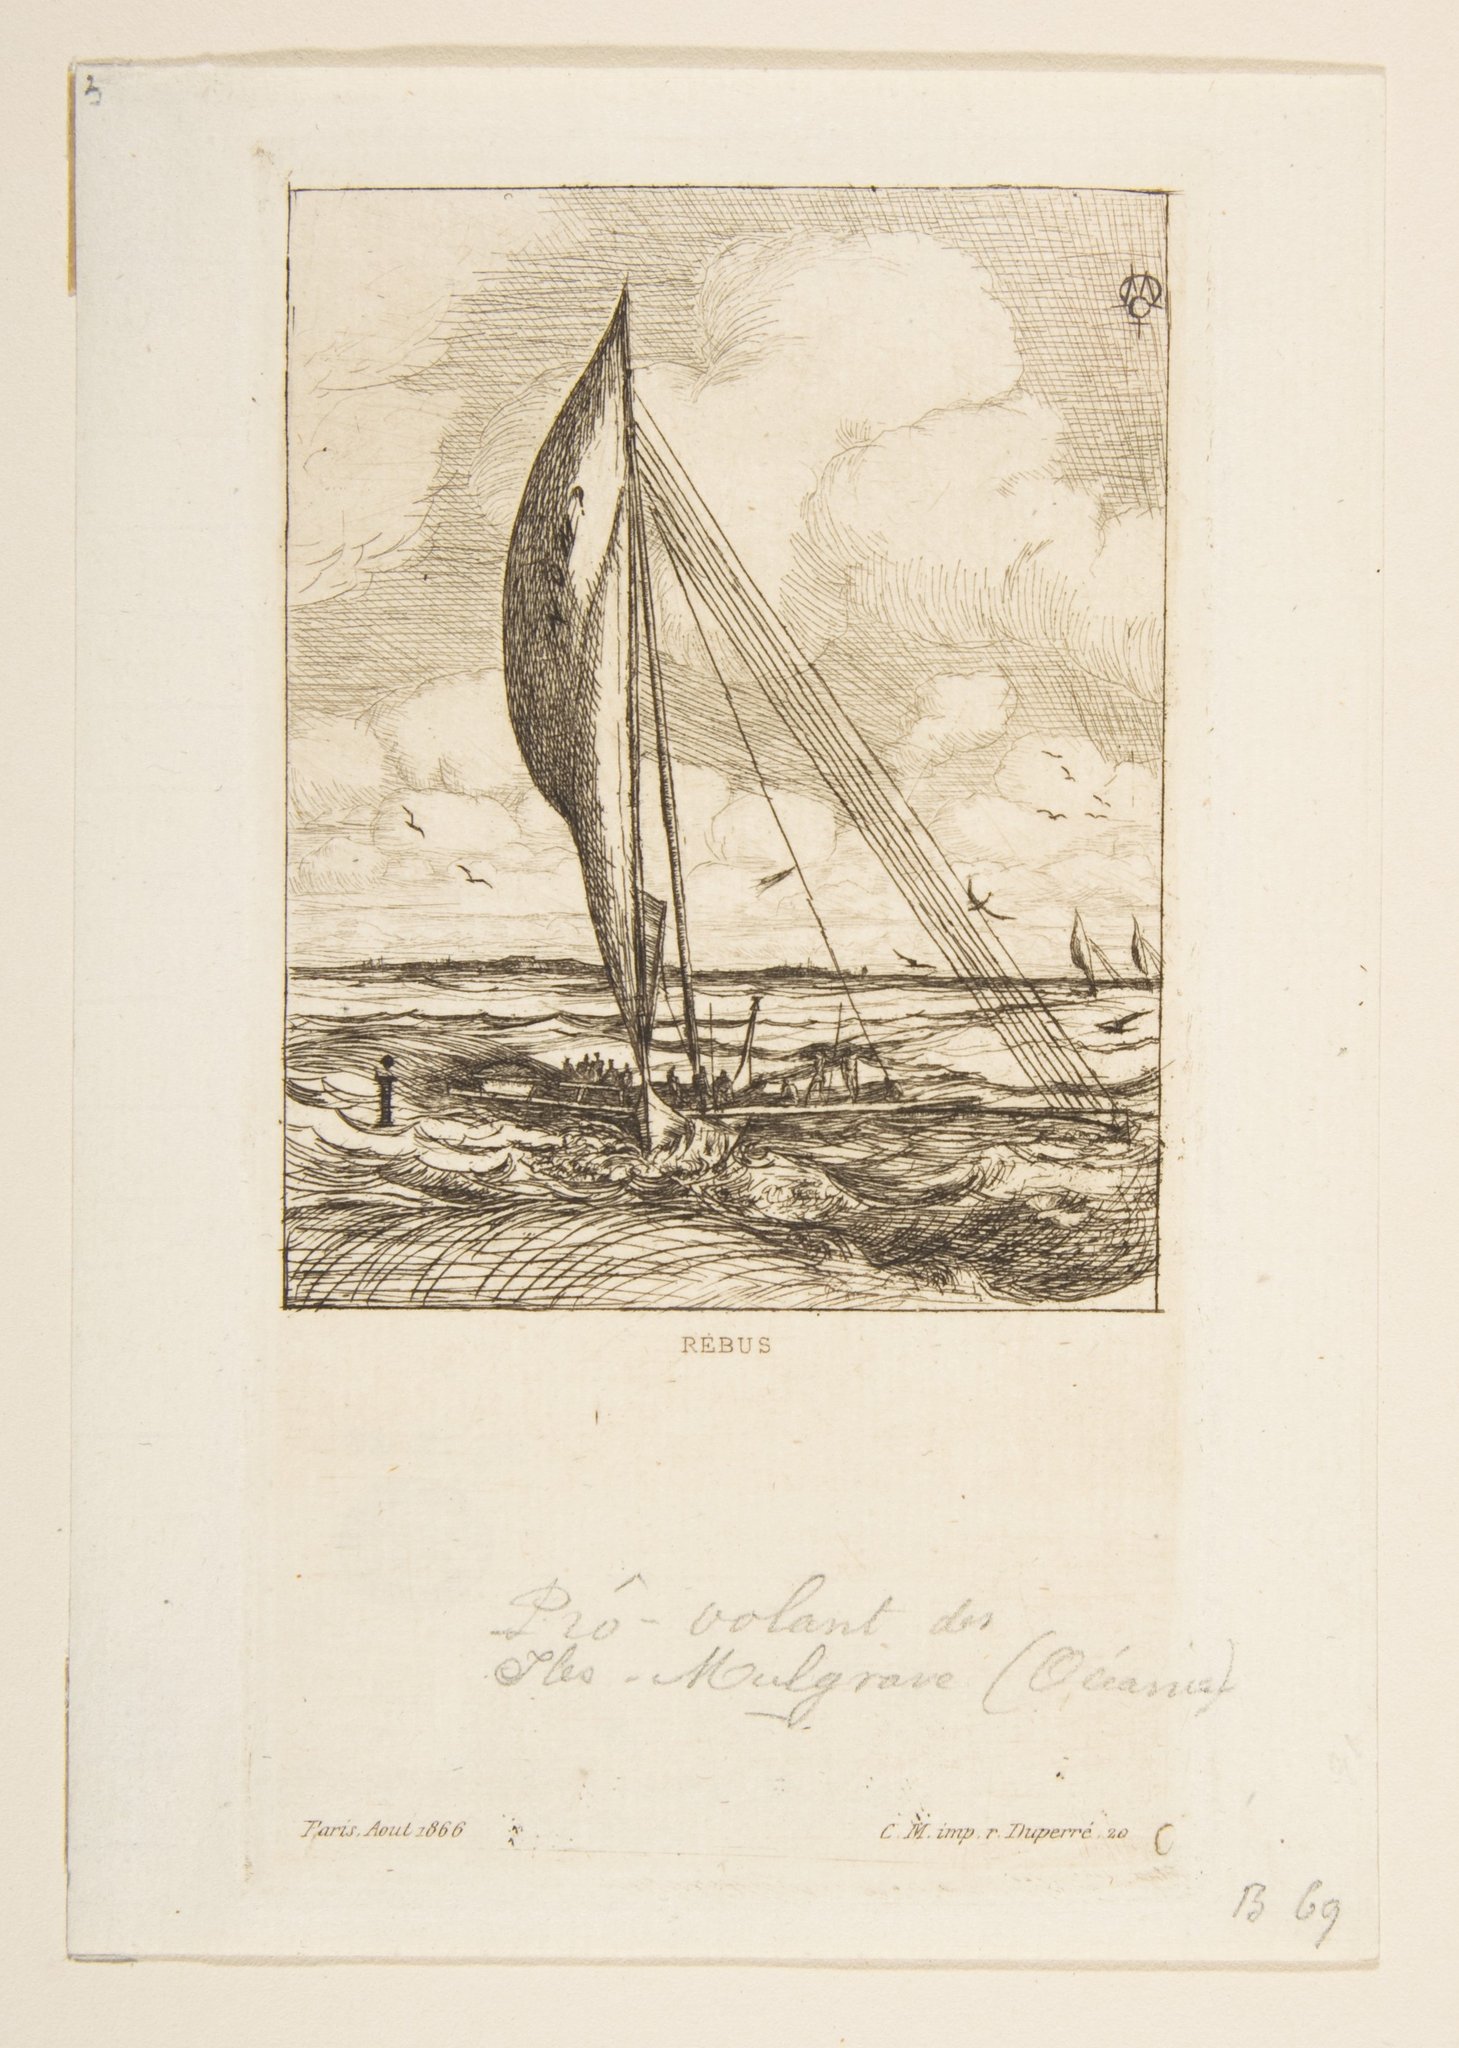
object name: print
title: Pro-Volant des Iles Mulgrave, from "The Voyage to New Zealand (1842–46)"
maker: charles meryon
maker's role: artist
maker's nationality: french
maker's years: 1821-1868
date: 1866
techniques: drypoint, etching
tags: boats